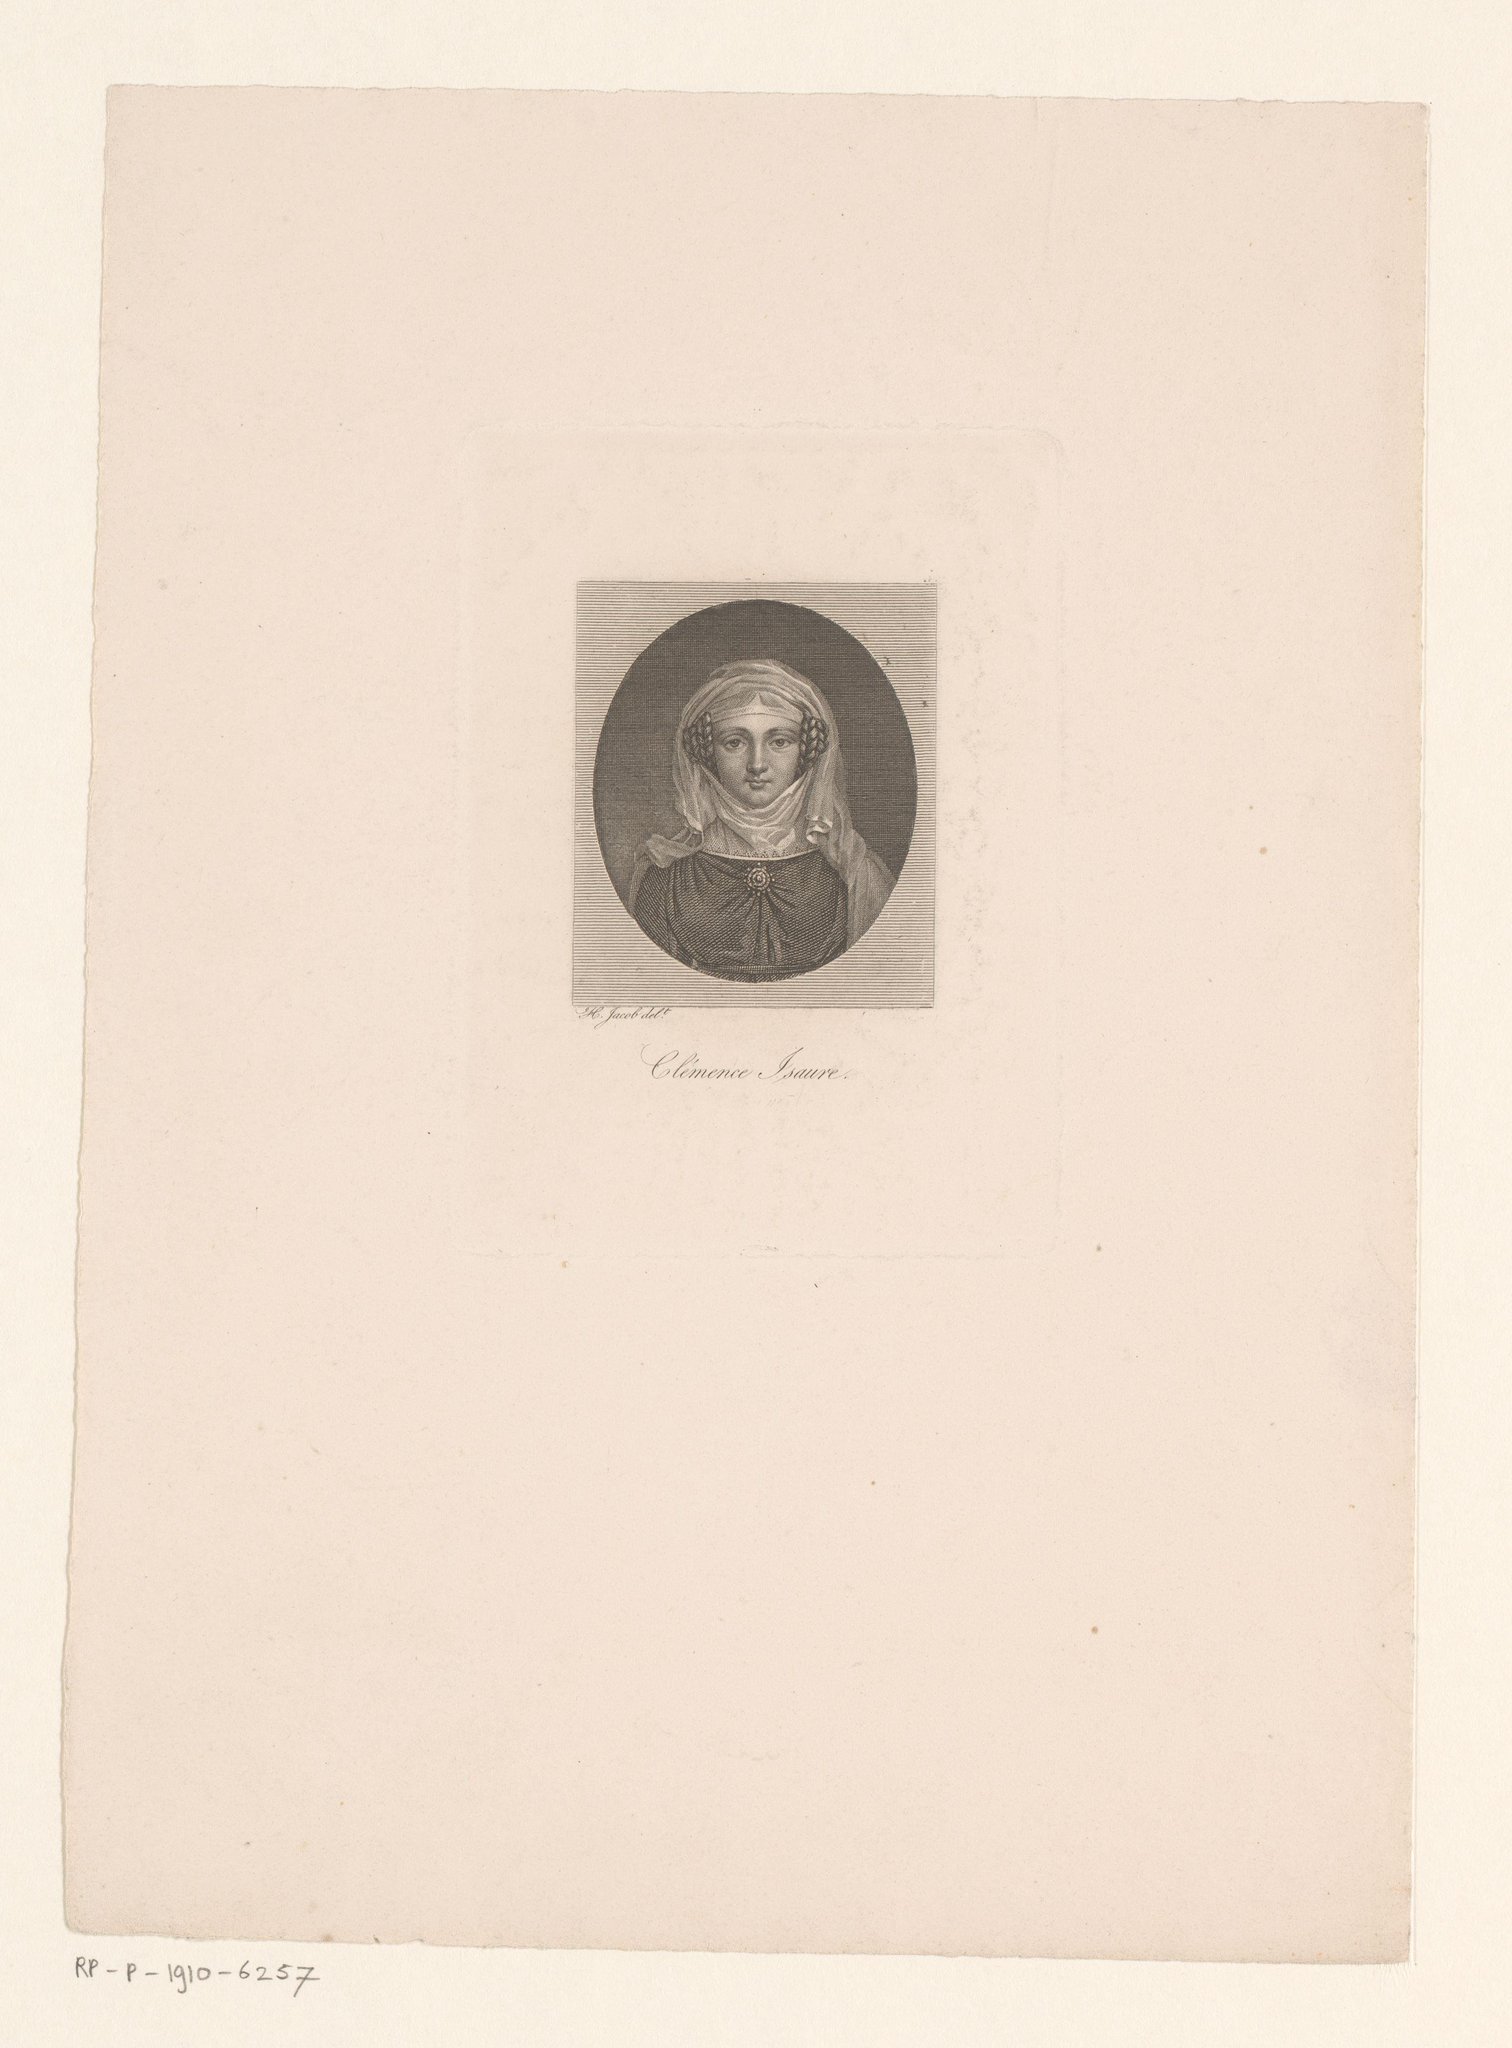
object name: print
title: Clemence Isaure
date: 1800-1899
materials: paper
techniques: etching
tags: historical persons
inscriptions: collector's mark: Lugt 2228